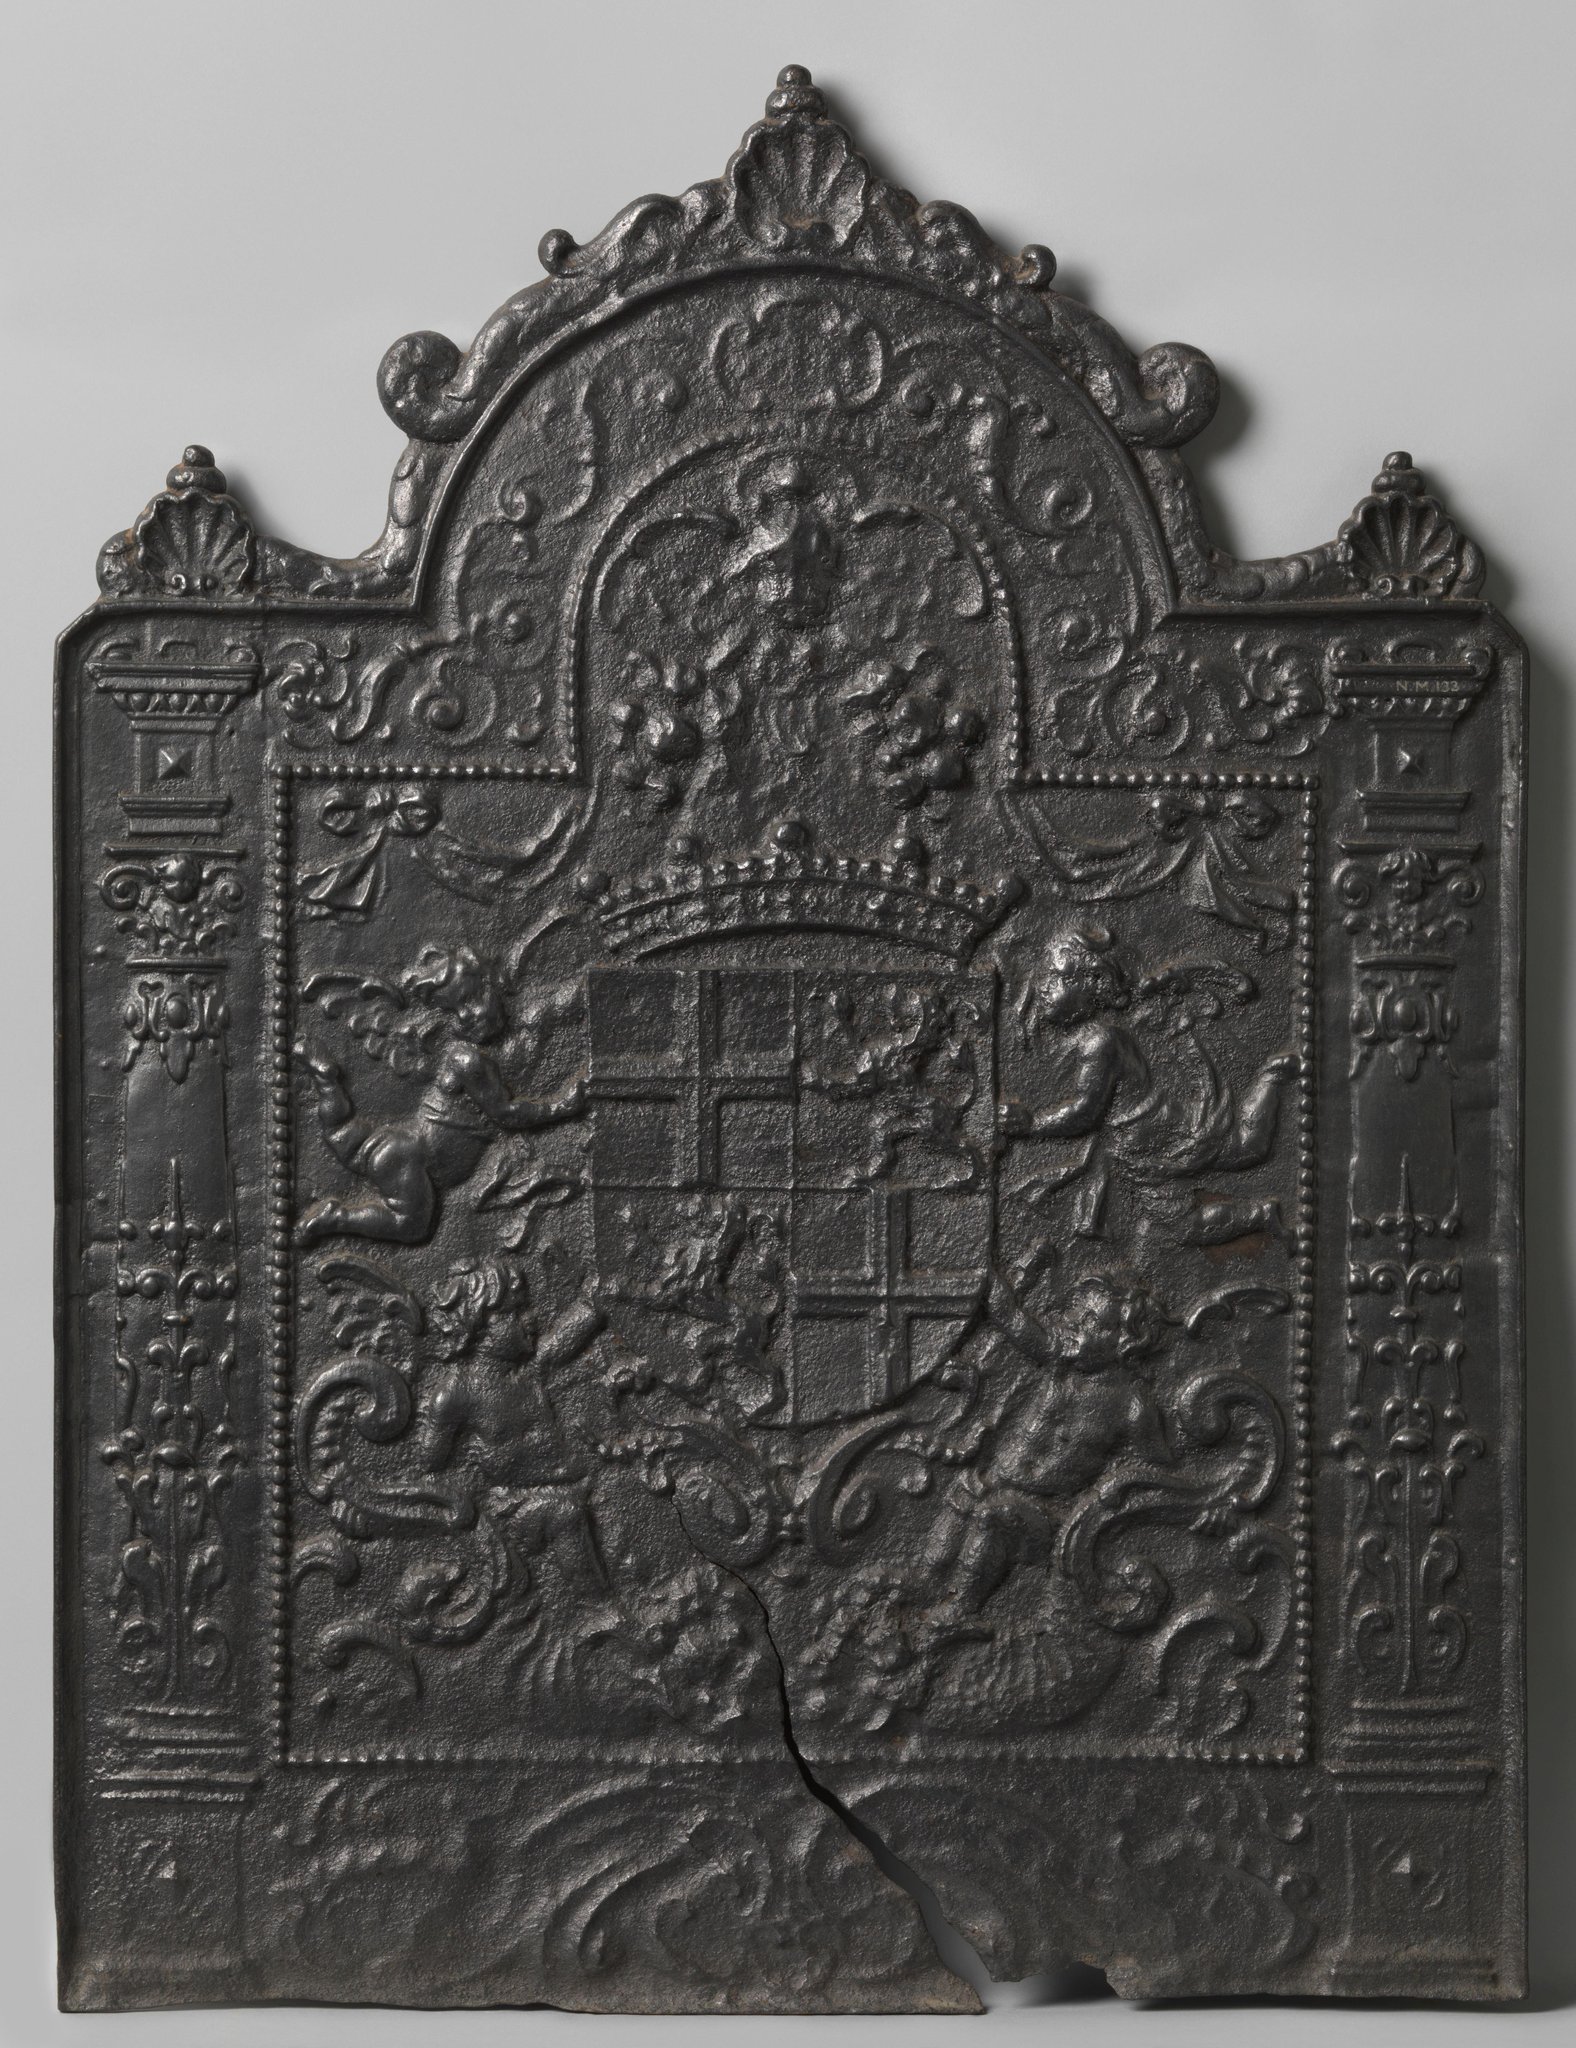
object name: fireback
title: Haardplaat met het wapen van de provincie Utrecht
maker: Anonymous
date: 1625-1675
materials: iron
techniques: casting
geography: germany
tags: utrecht (provincie)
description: Haardplaat van gietijzer, met halfronde bovenzijde. In het midden is het gekroonde wapenschild van de provincie Utrecht, dat wordt opgehouden door vier putti. Daarboven een mascaron. Het tafereel wordt omlijst door een parelrand en een versierde buitenrand, met boven- en onderaan bladranken en aan beide zijden een colonnet. Het geheel wordt bekroond met drie schelpmotieven, met aan weerszijden een omhoogklimmende dolfijn.